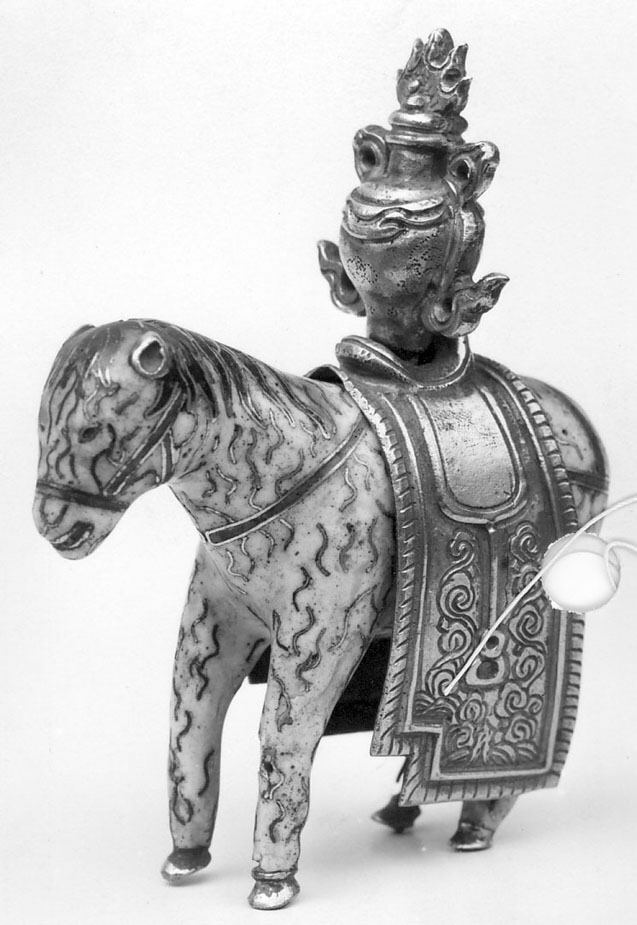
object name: statuette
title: Horse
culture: chinese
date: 1701-1800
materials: enamel, gilt, metal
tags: horses